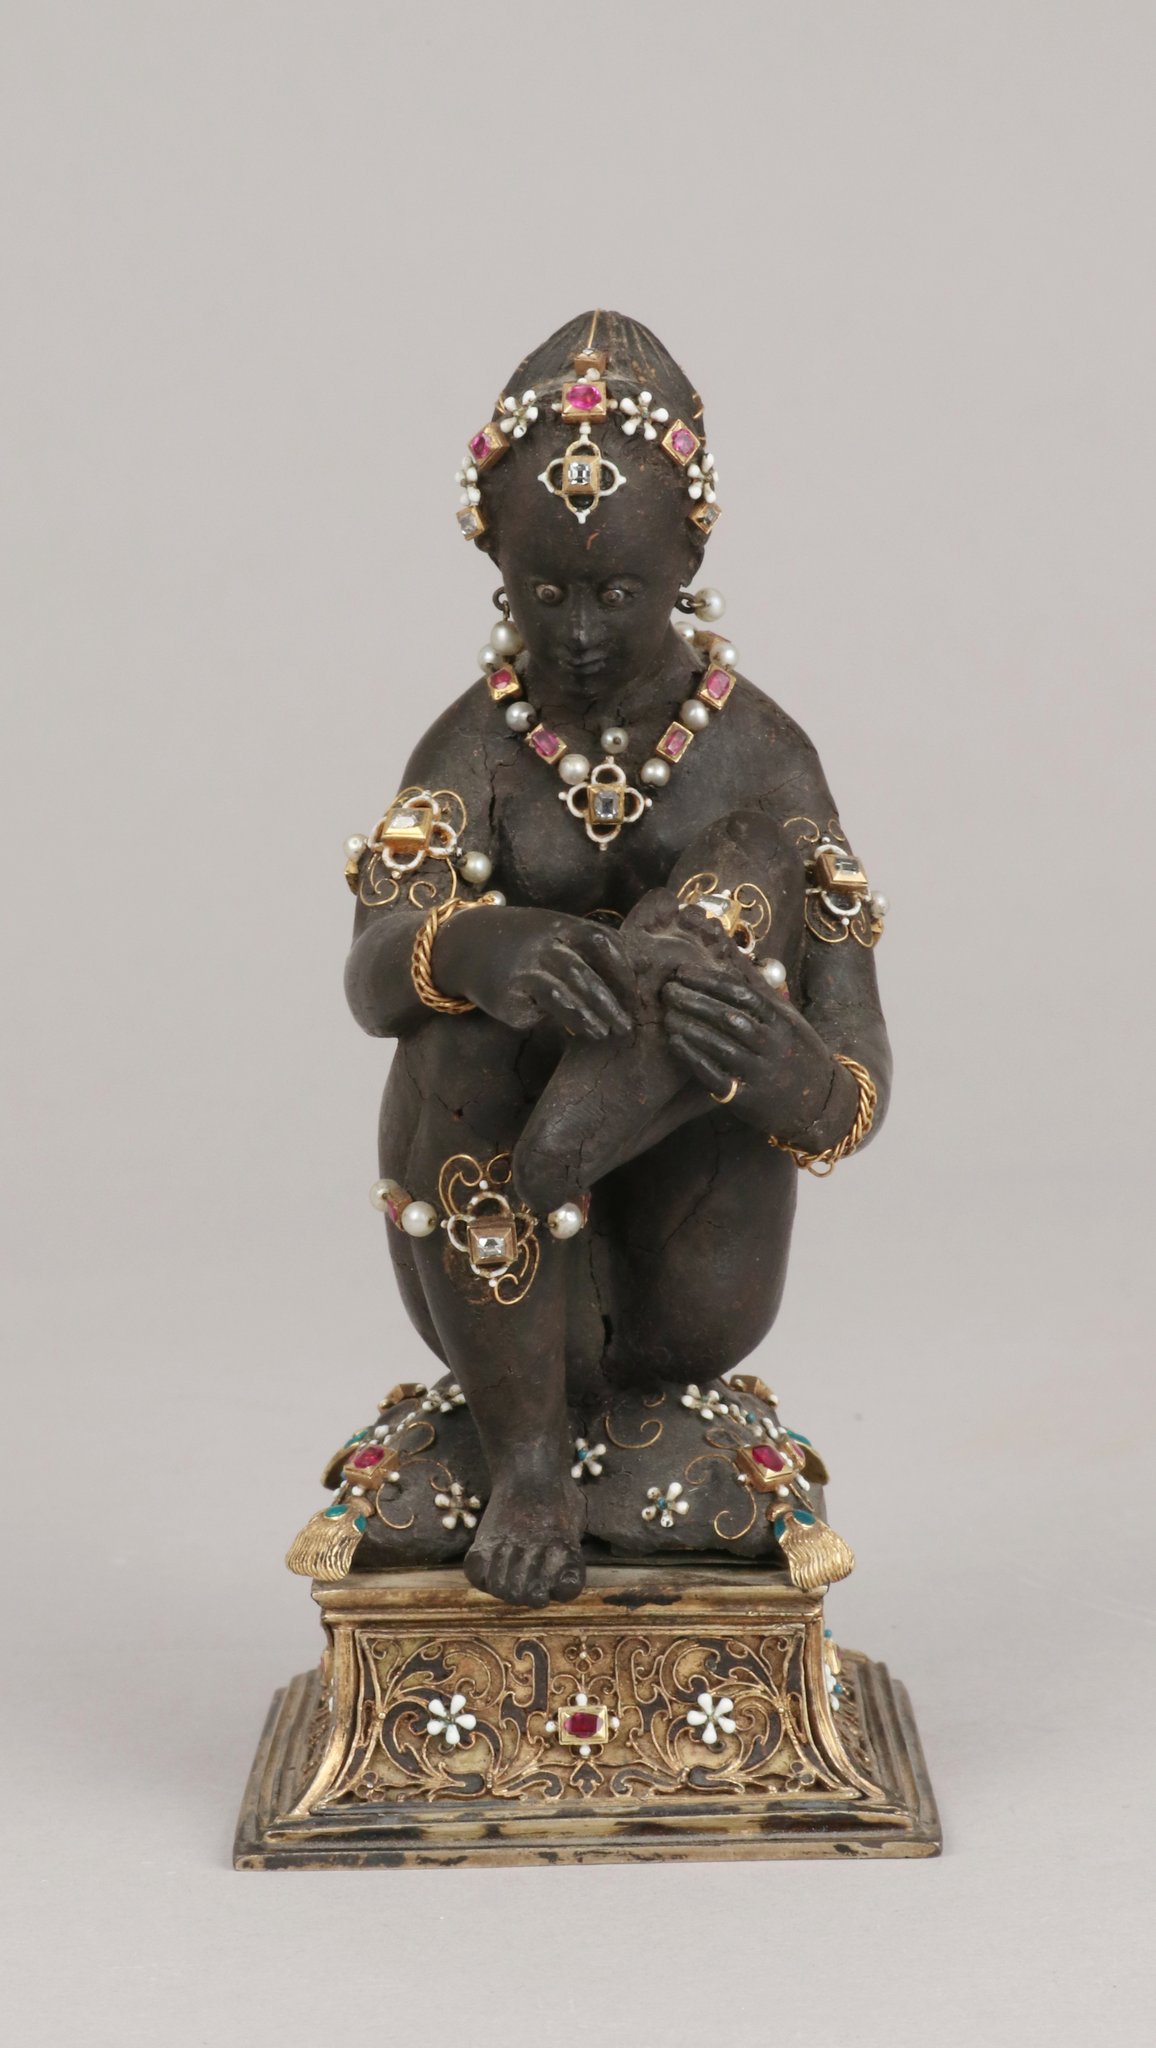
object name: statuette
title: Woman pulling a thorn from her foot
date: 1801-1900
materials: enamel, gold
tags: female nudes,flowers